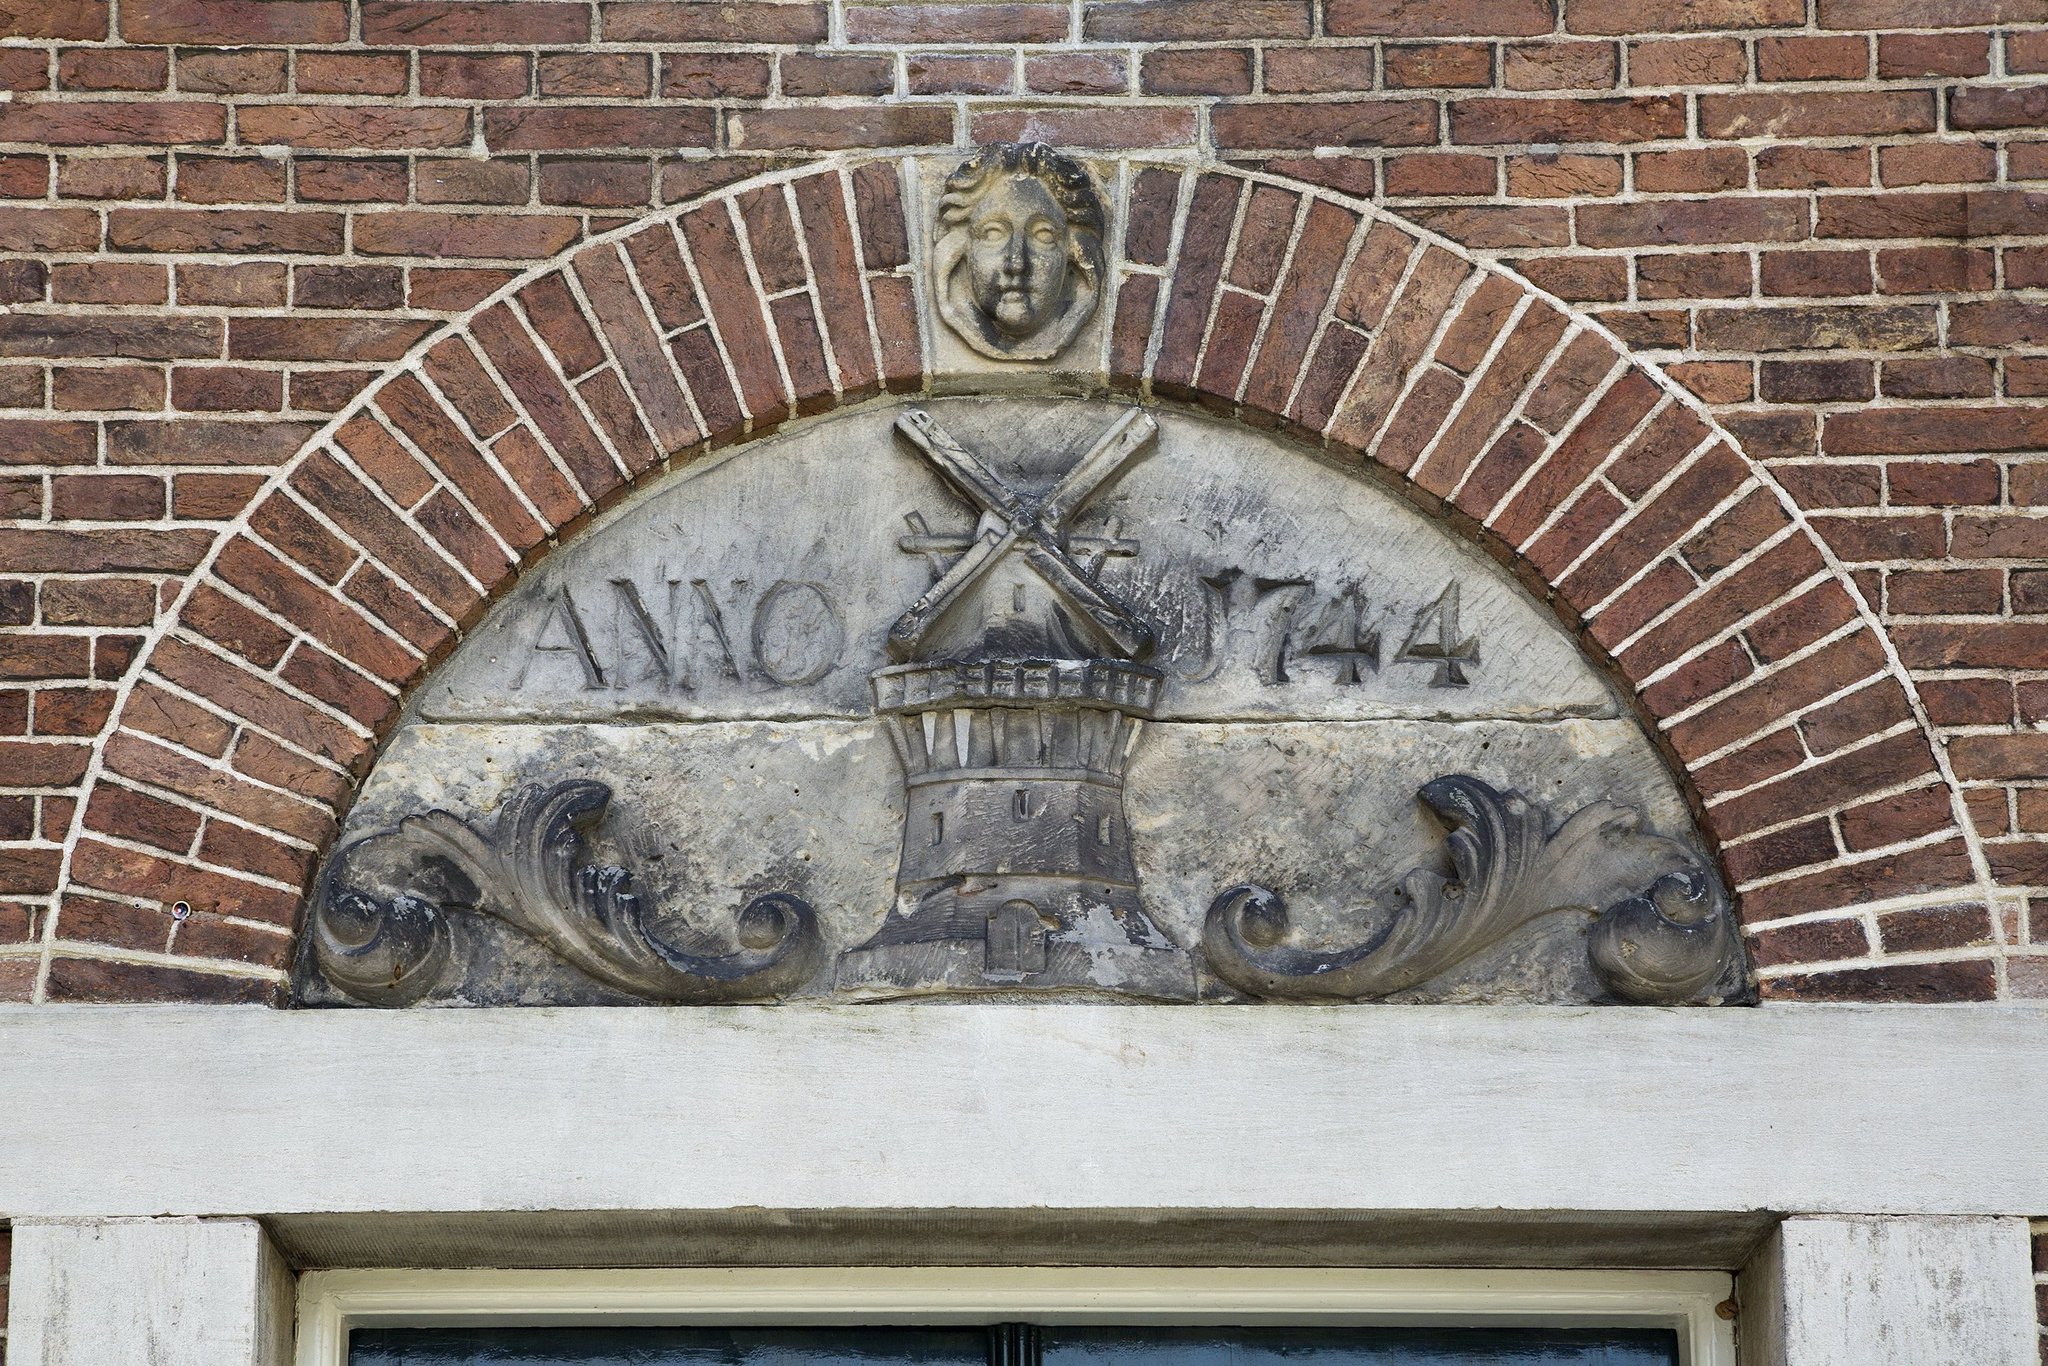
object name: architectural element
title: Gevelsteen met molen en jaartal 1744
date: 1744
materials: stone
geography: amsterdam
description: Een gevelsteen, afkomstig van een woning, die behoord bij de molen "de Wetering" Amsterdam (?) Op de steen een afbeelding van de molen en jaartal Anno 1744. In twee stukken. Het bovengedeelte cirkelvormig.